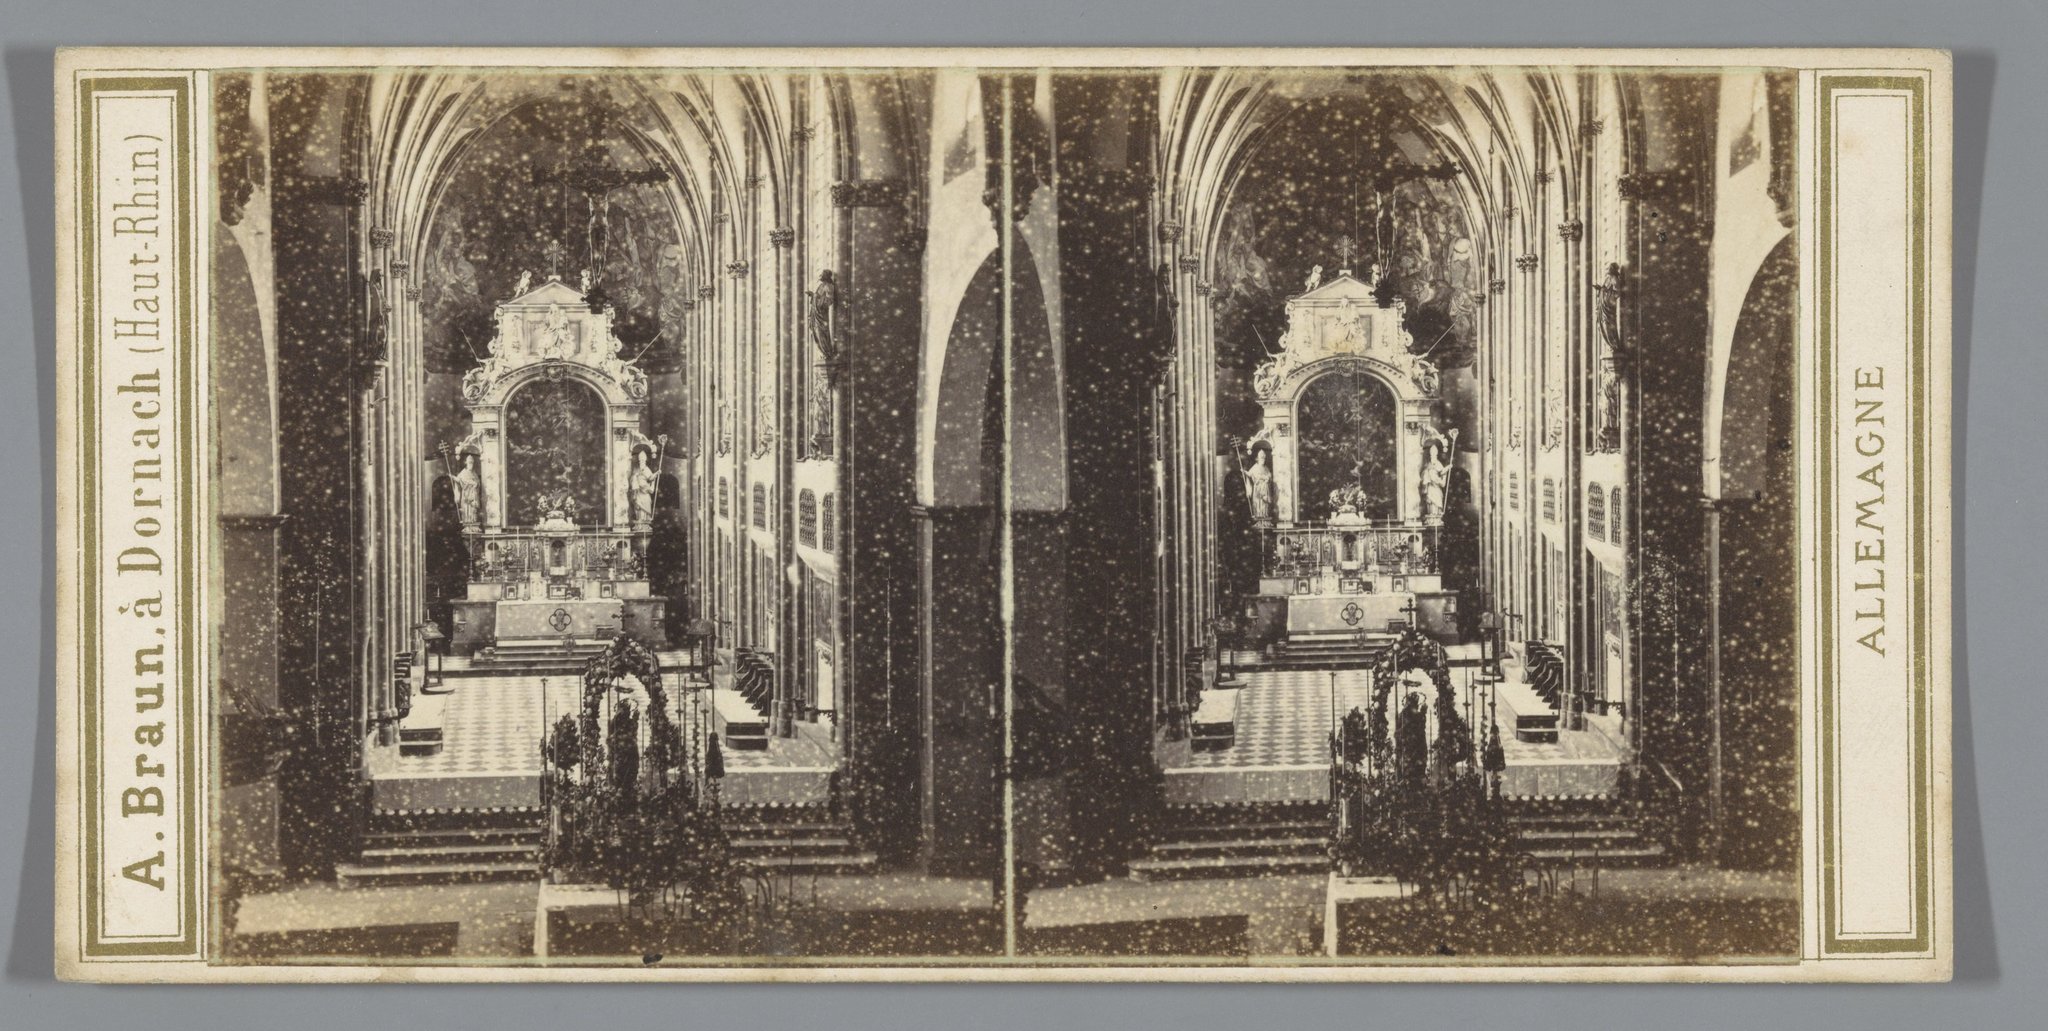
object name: stereograph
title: Allemagne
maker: Anonymous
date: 1860-1866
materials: cardboard, paper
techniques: albumen print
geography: cologne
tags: interior of church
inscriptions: number: ‘No 4195.’, inscription: ‘Cologne/ St Ursule’